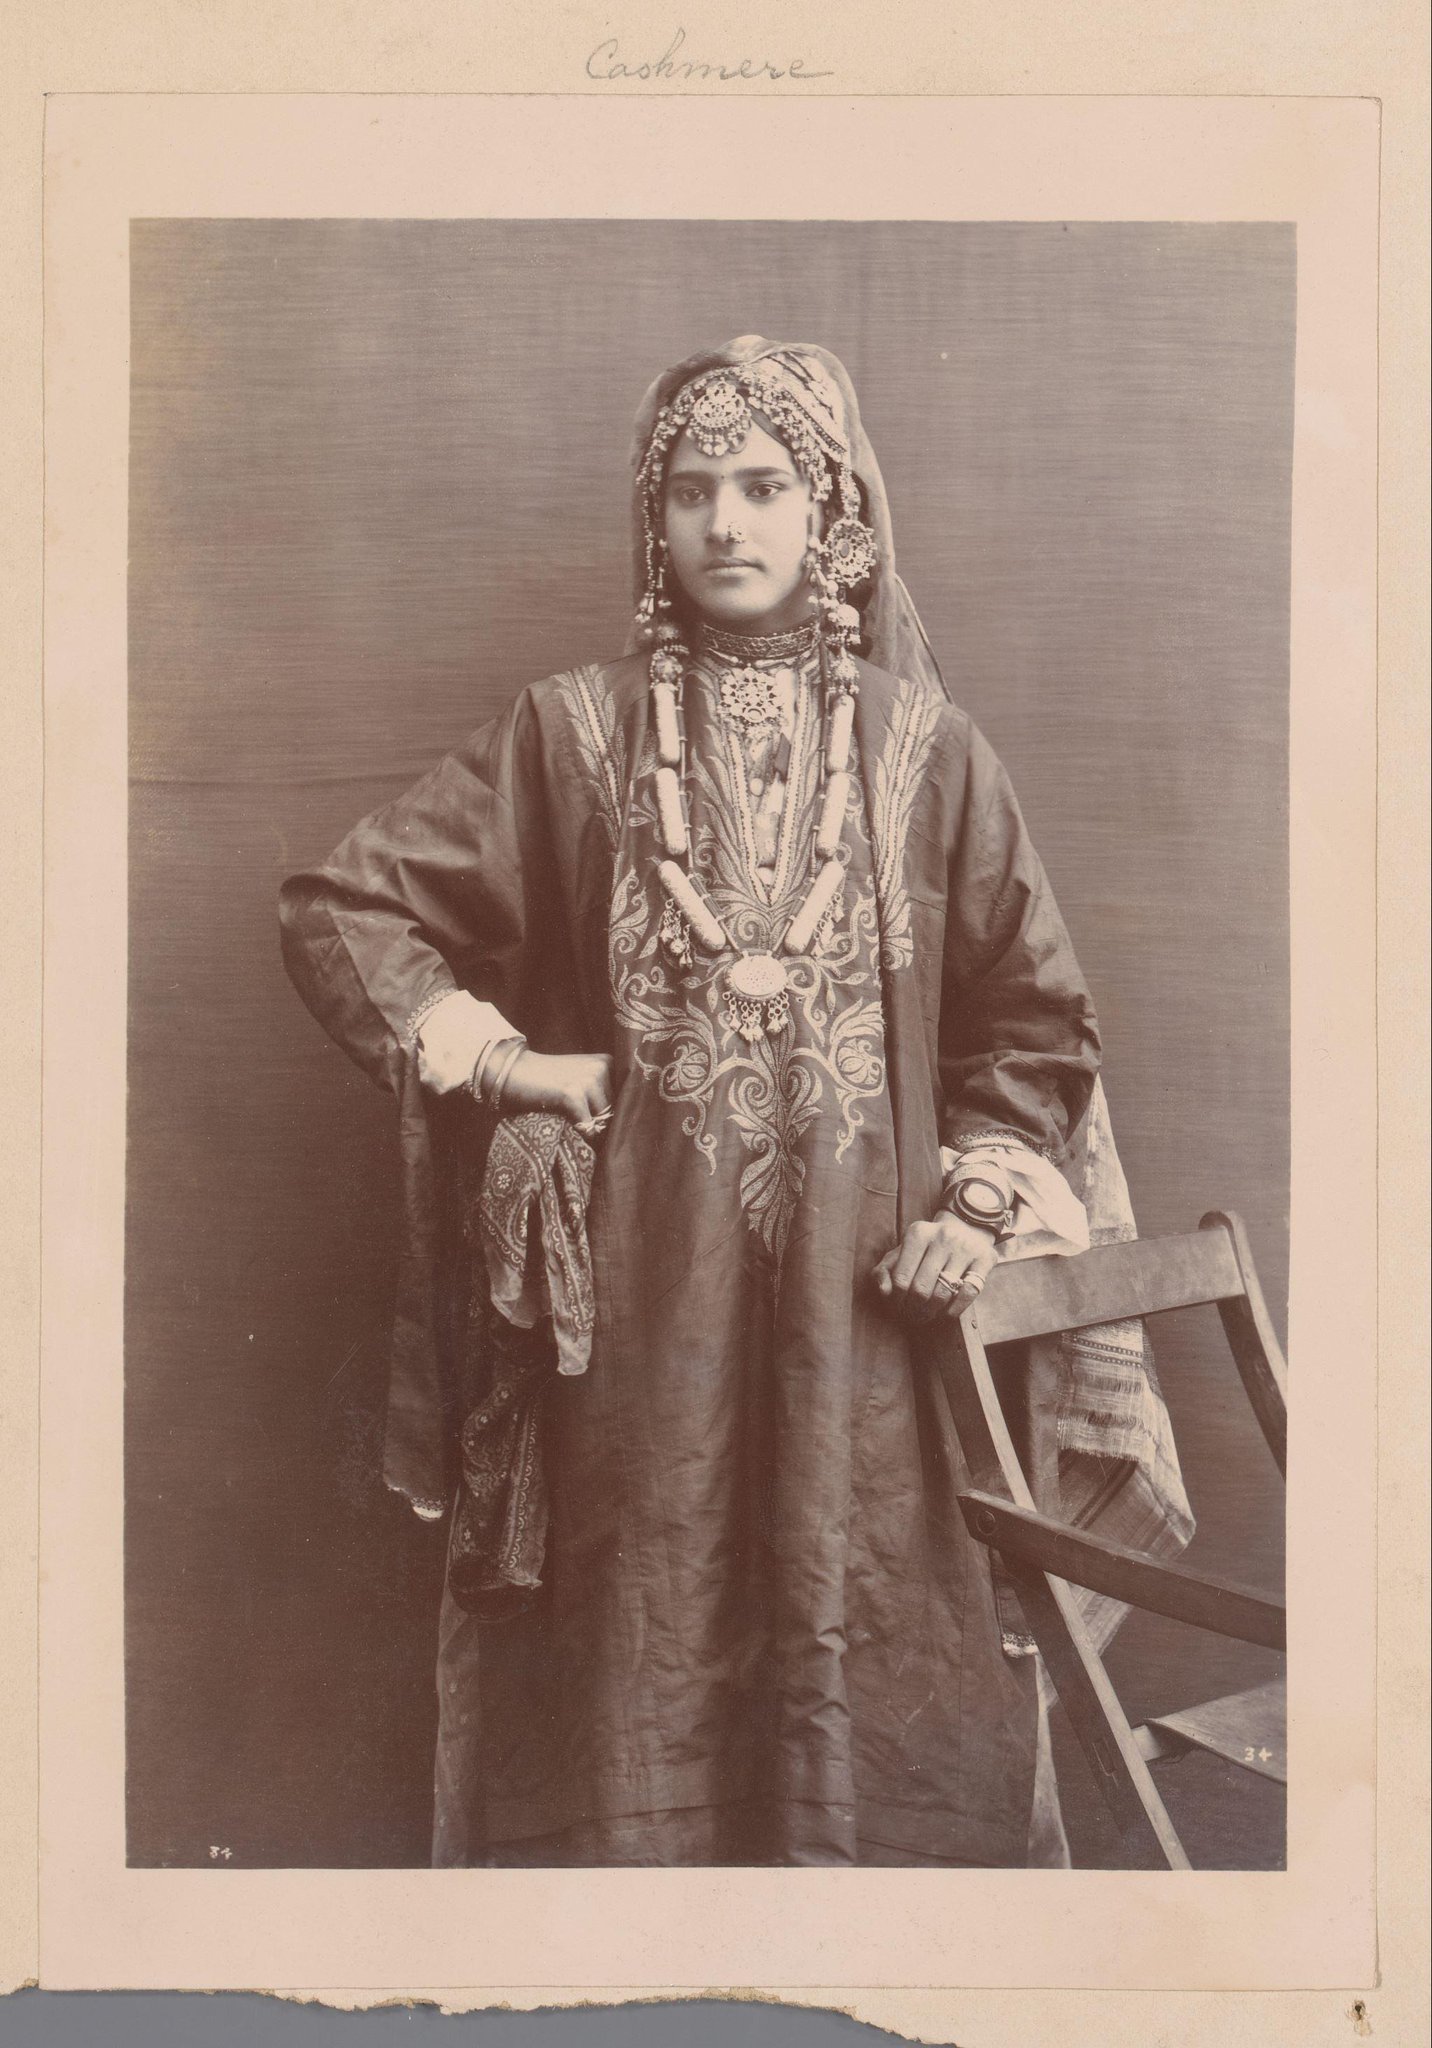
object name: photograph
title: Portret van een staande vrouw in lang traditioneel gewaad, Kasjmir, India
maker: Anonymous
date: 1875-1910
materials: cardboard, photographic support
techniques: albumen print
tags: kasjmir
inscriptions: inscription: ‘34’, inscription: ‘Cashmere’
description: Portret van een staande vrouw in lang en rijkversierd traditioneel gewaad, Kasjmir, India. Ze draagt een neussierraad en polshorloge [?].